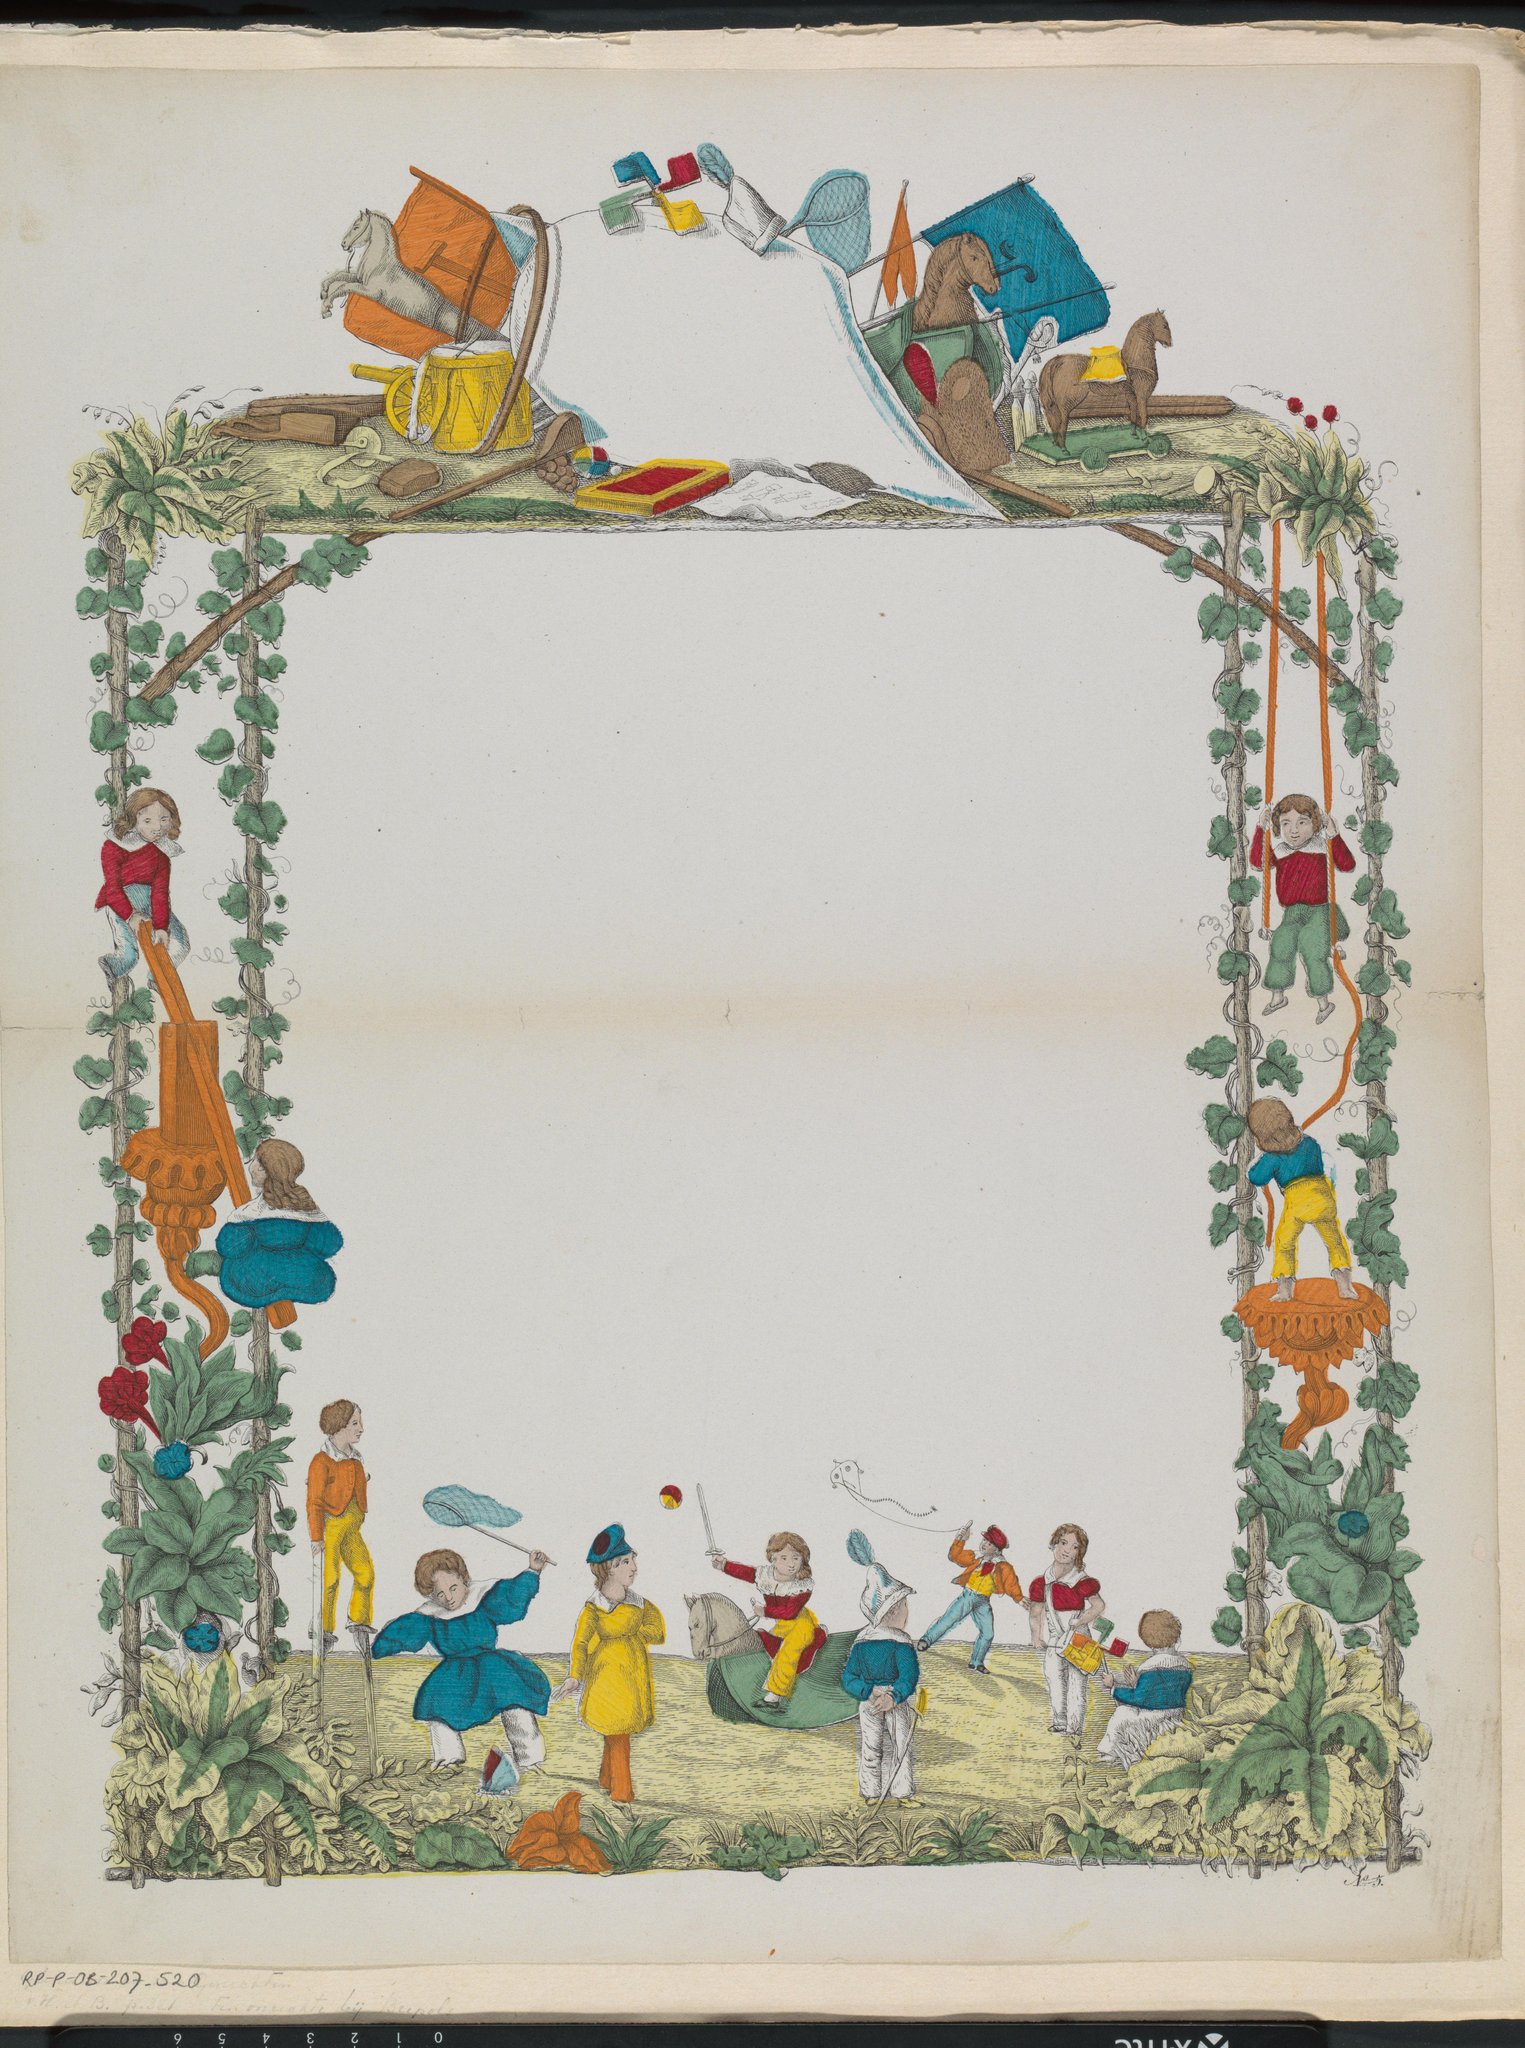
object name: print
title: Wensbrief met spelende kinderen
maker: Anonymous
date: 1780-1899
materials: paper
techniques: colour, lithograph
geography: netherlands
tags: children's games and plays, swinging (children's game), (flying a) kite, seesaw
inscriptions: collector's mark: Lugt 2760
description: Wensbrief met onbeschreven cartouche binnen een decoratief kader met voorstellingen van spelende kinderen en speelgoed. Genummerd rechtsonder: No. 5.